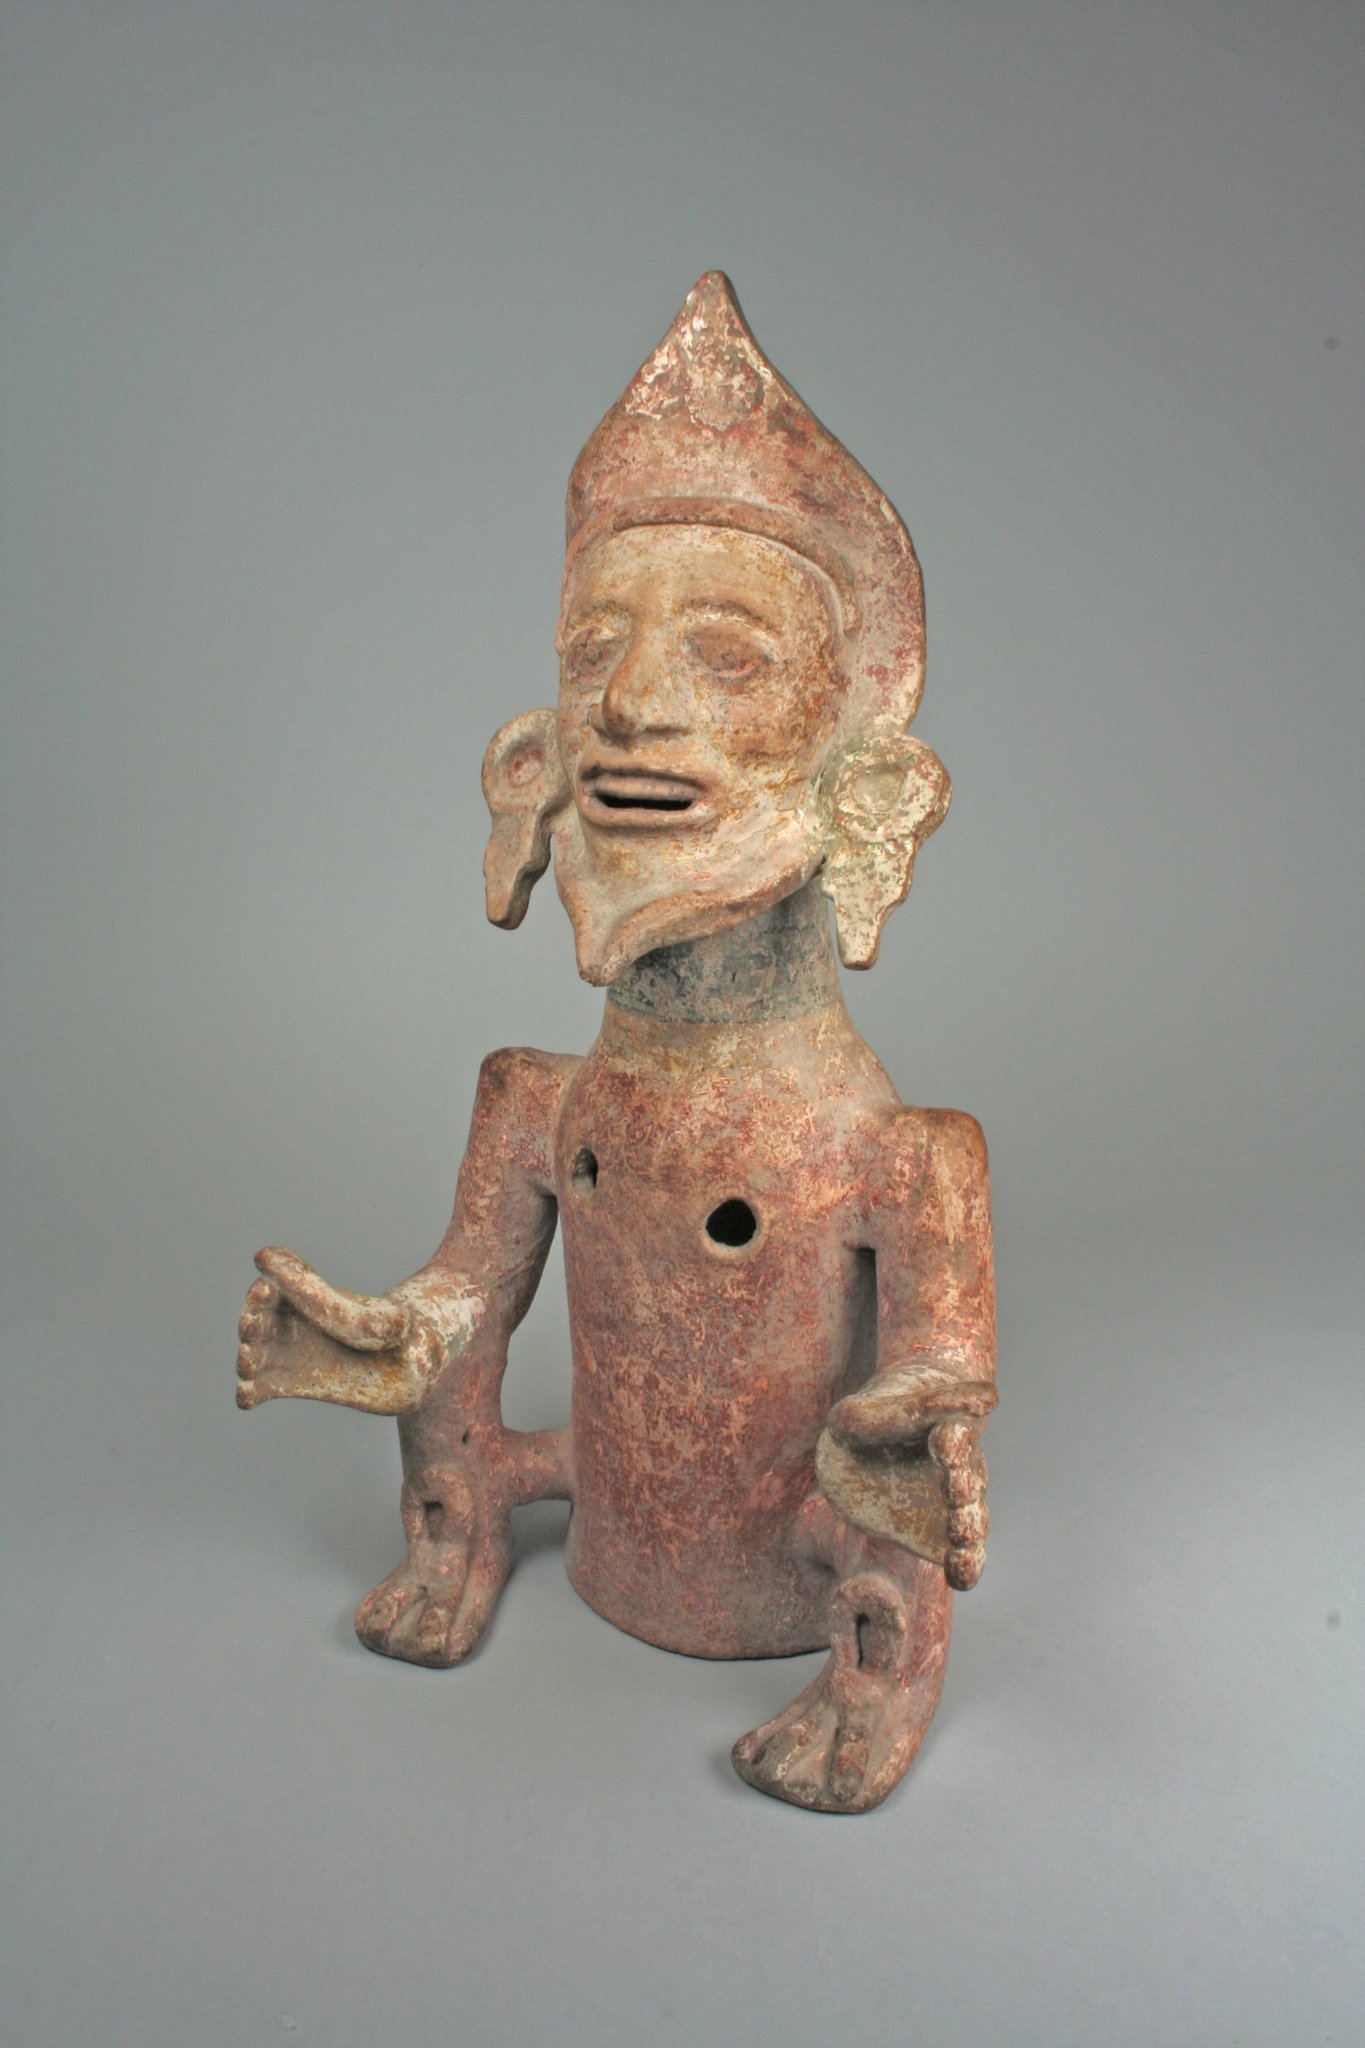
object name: male figure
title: Seated Figure (Xantil)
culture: eastern nahua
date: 1201-1500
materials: ceramic, pigment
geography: mexico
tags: men